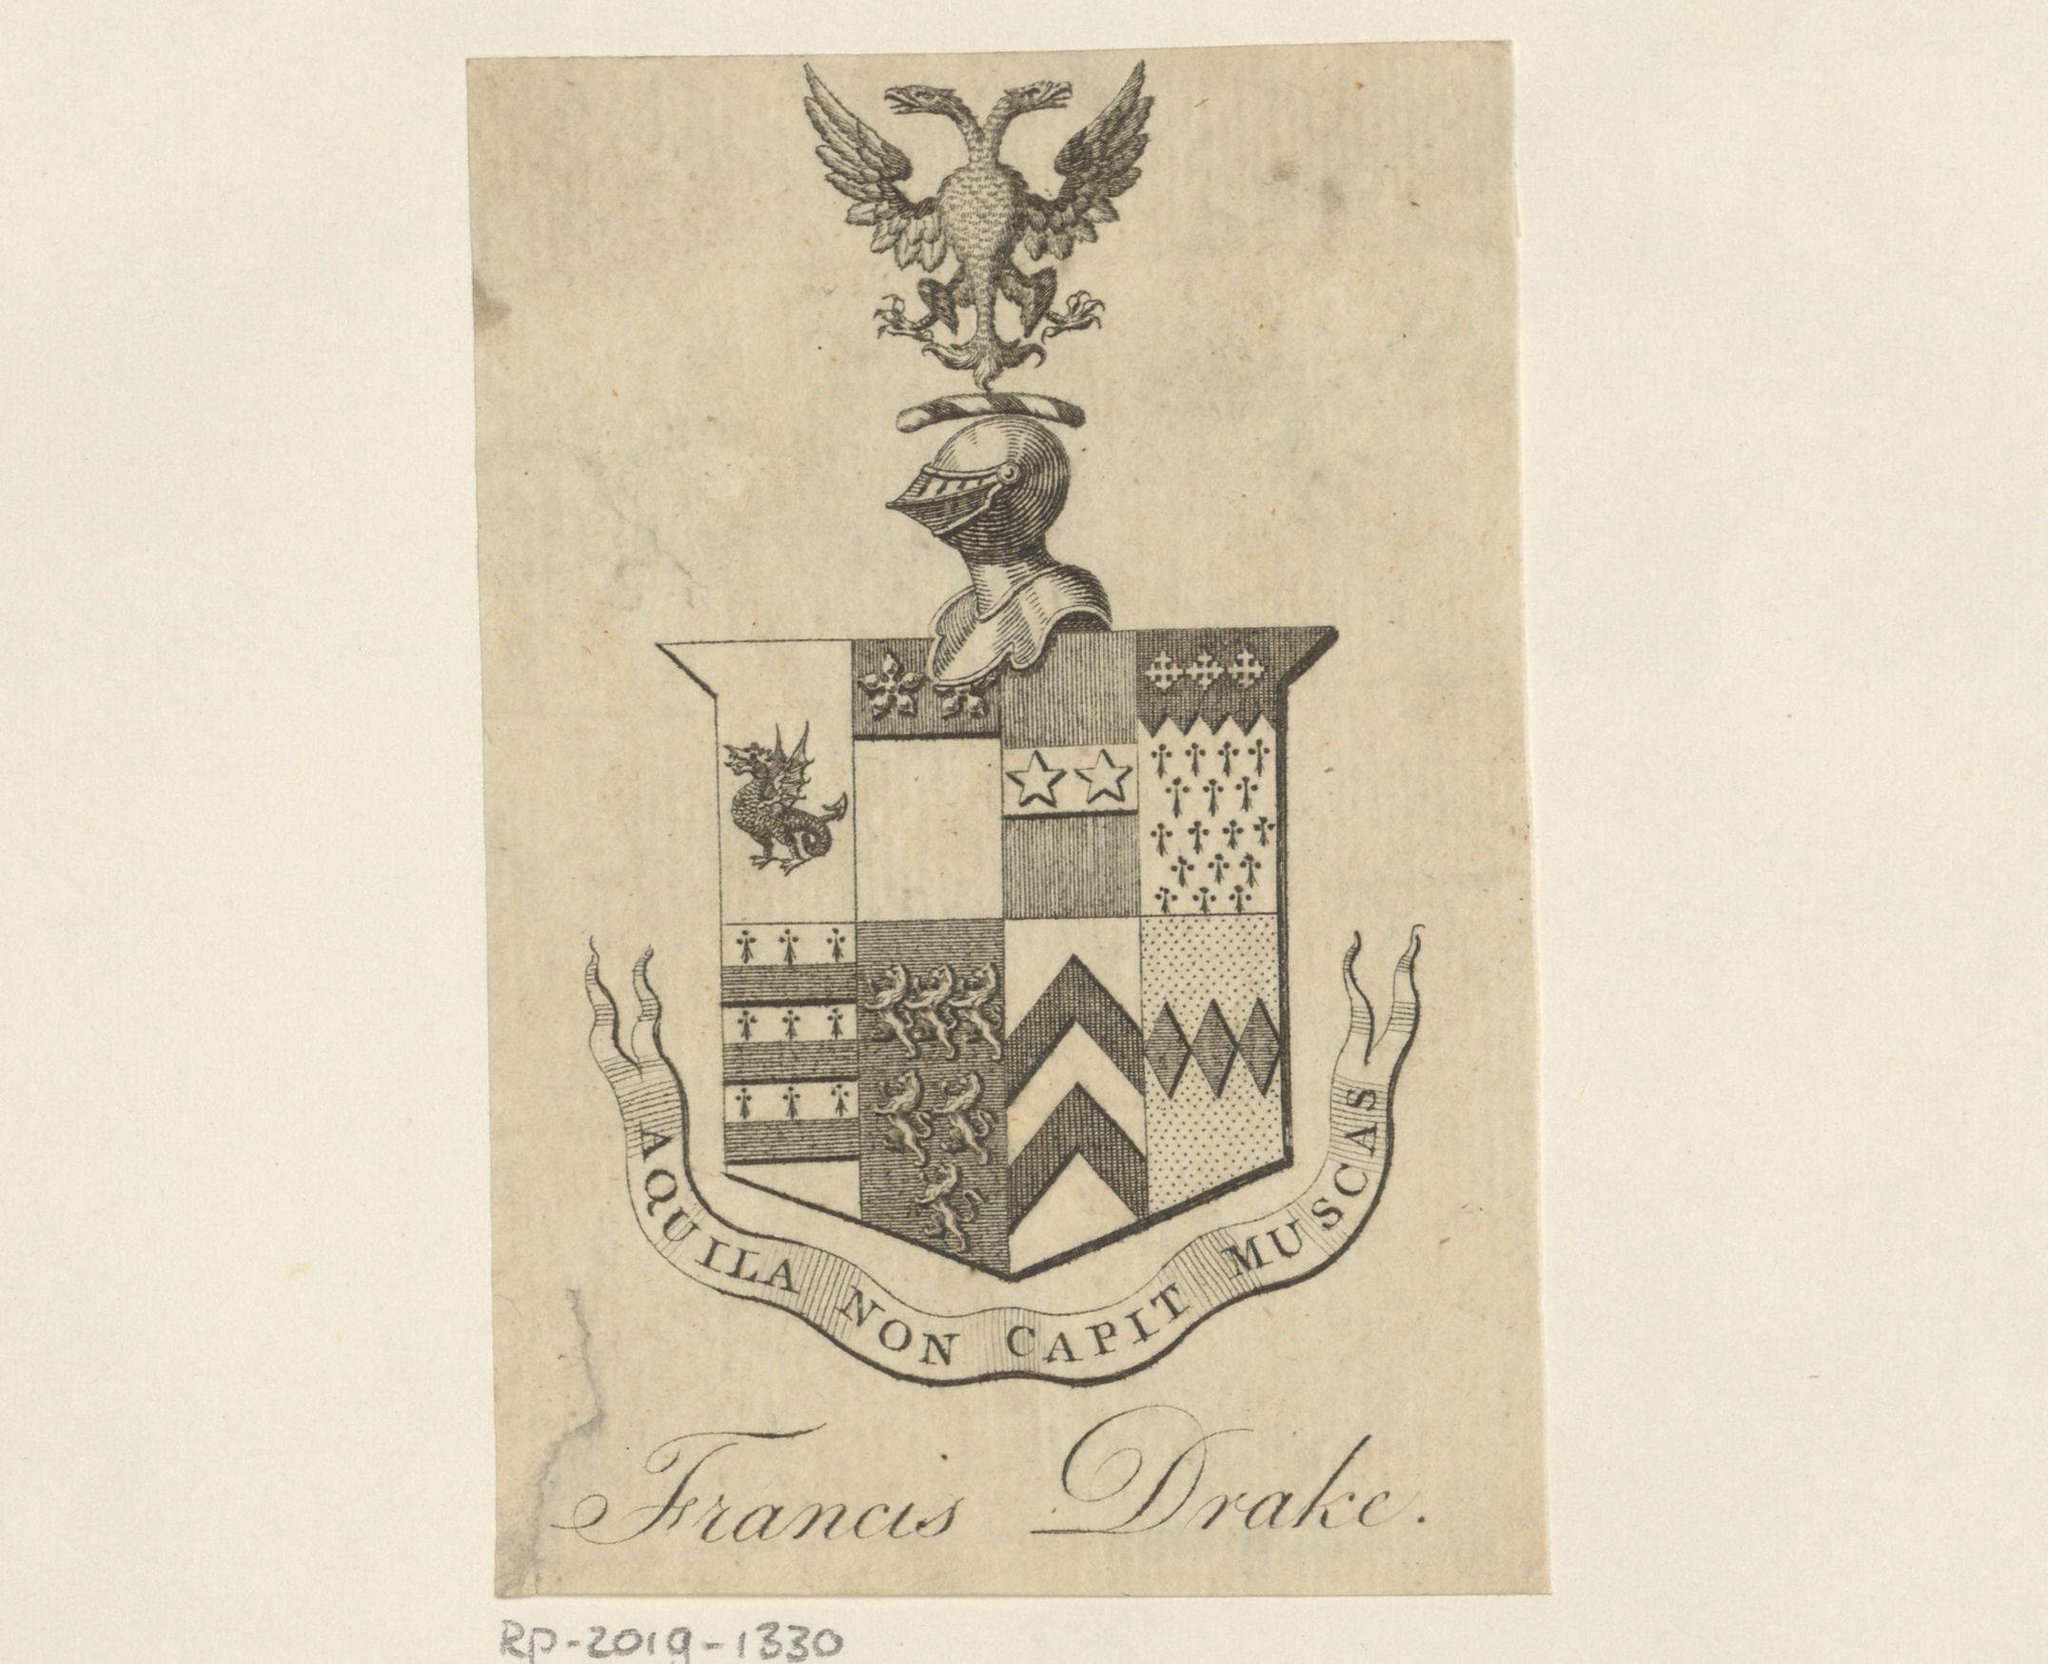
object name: bookplate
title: Aquila non capit muscas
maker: Anonymous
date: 1750-1849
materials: paper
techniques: engraving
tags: armorial bearing, heraldry